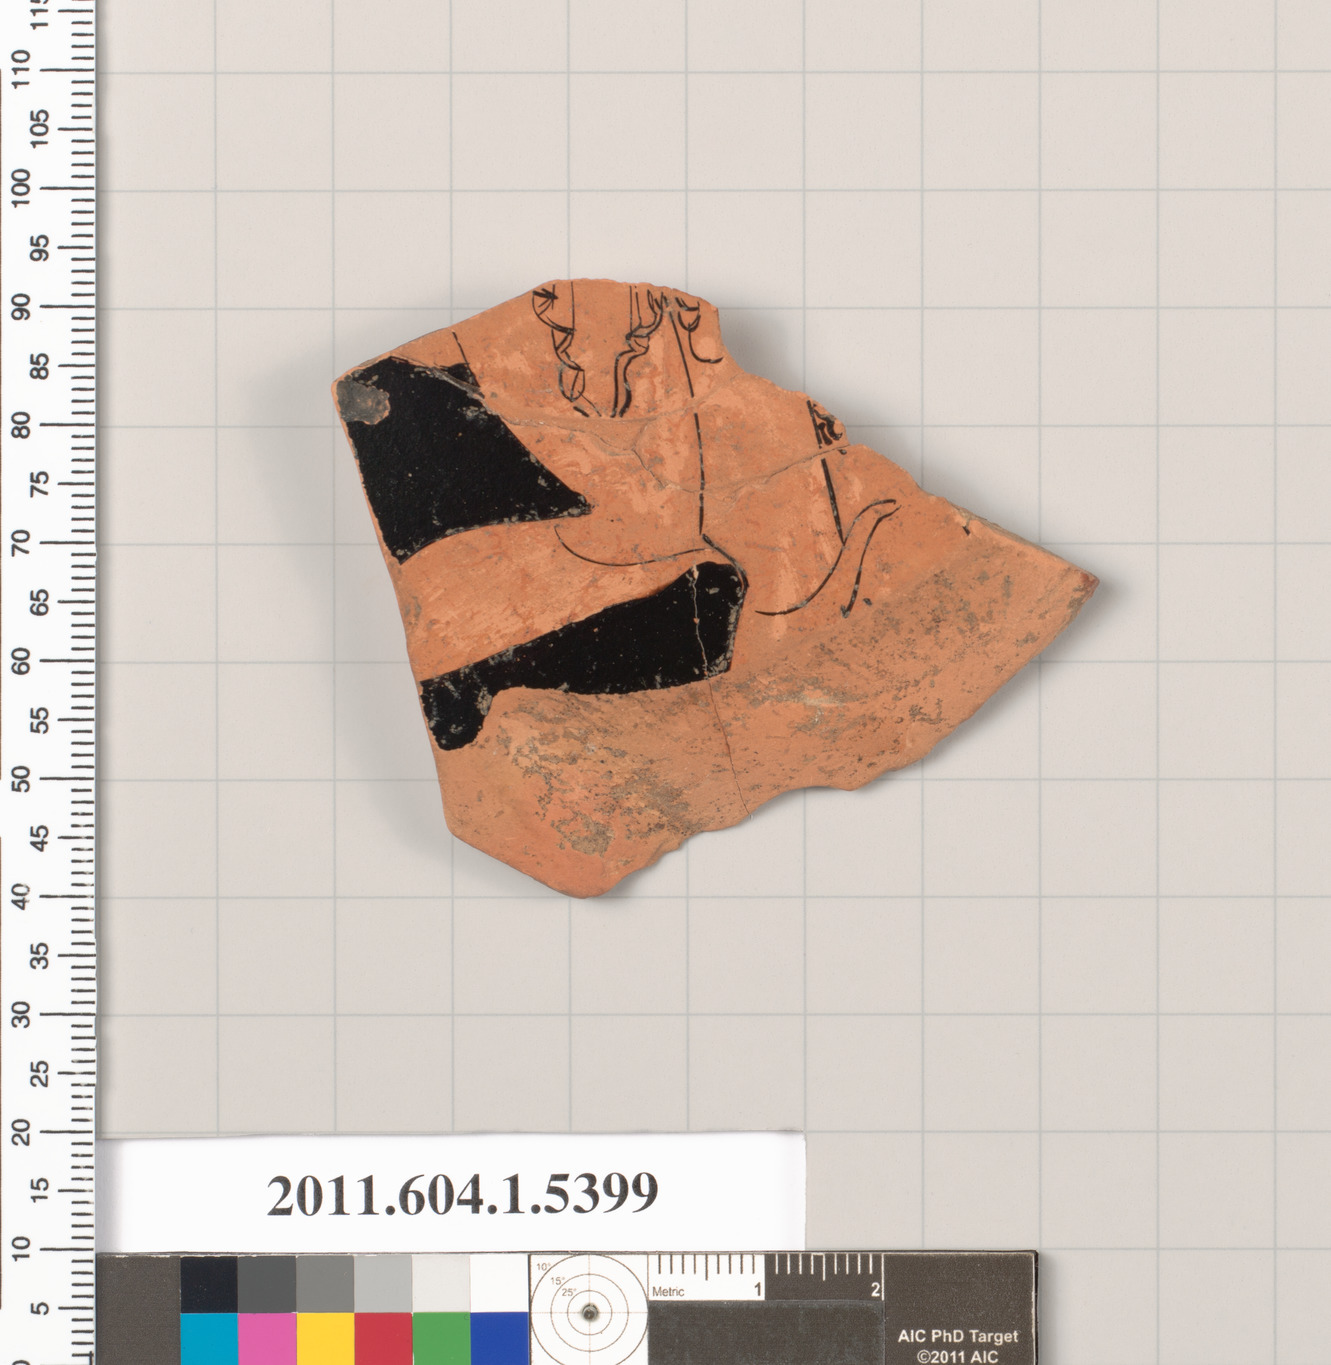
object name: kylix fragment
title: Terracotta fragment of a kylix (drinking cup)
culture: greek, attic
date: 510-490 BCE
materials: terracotta